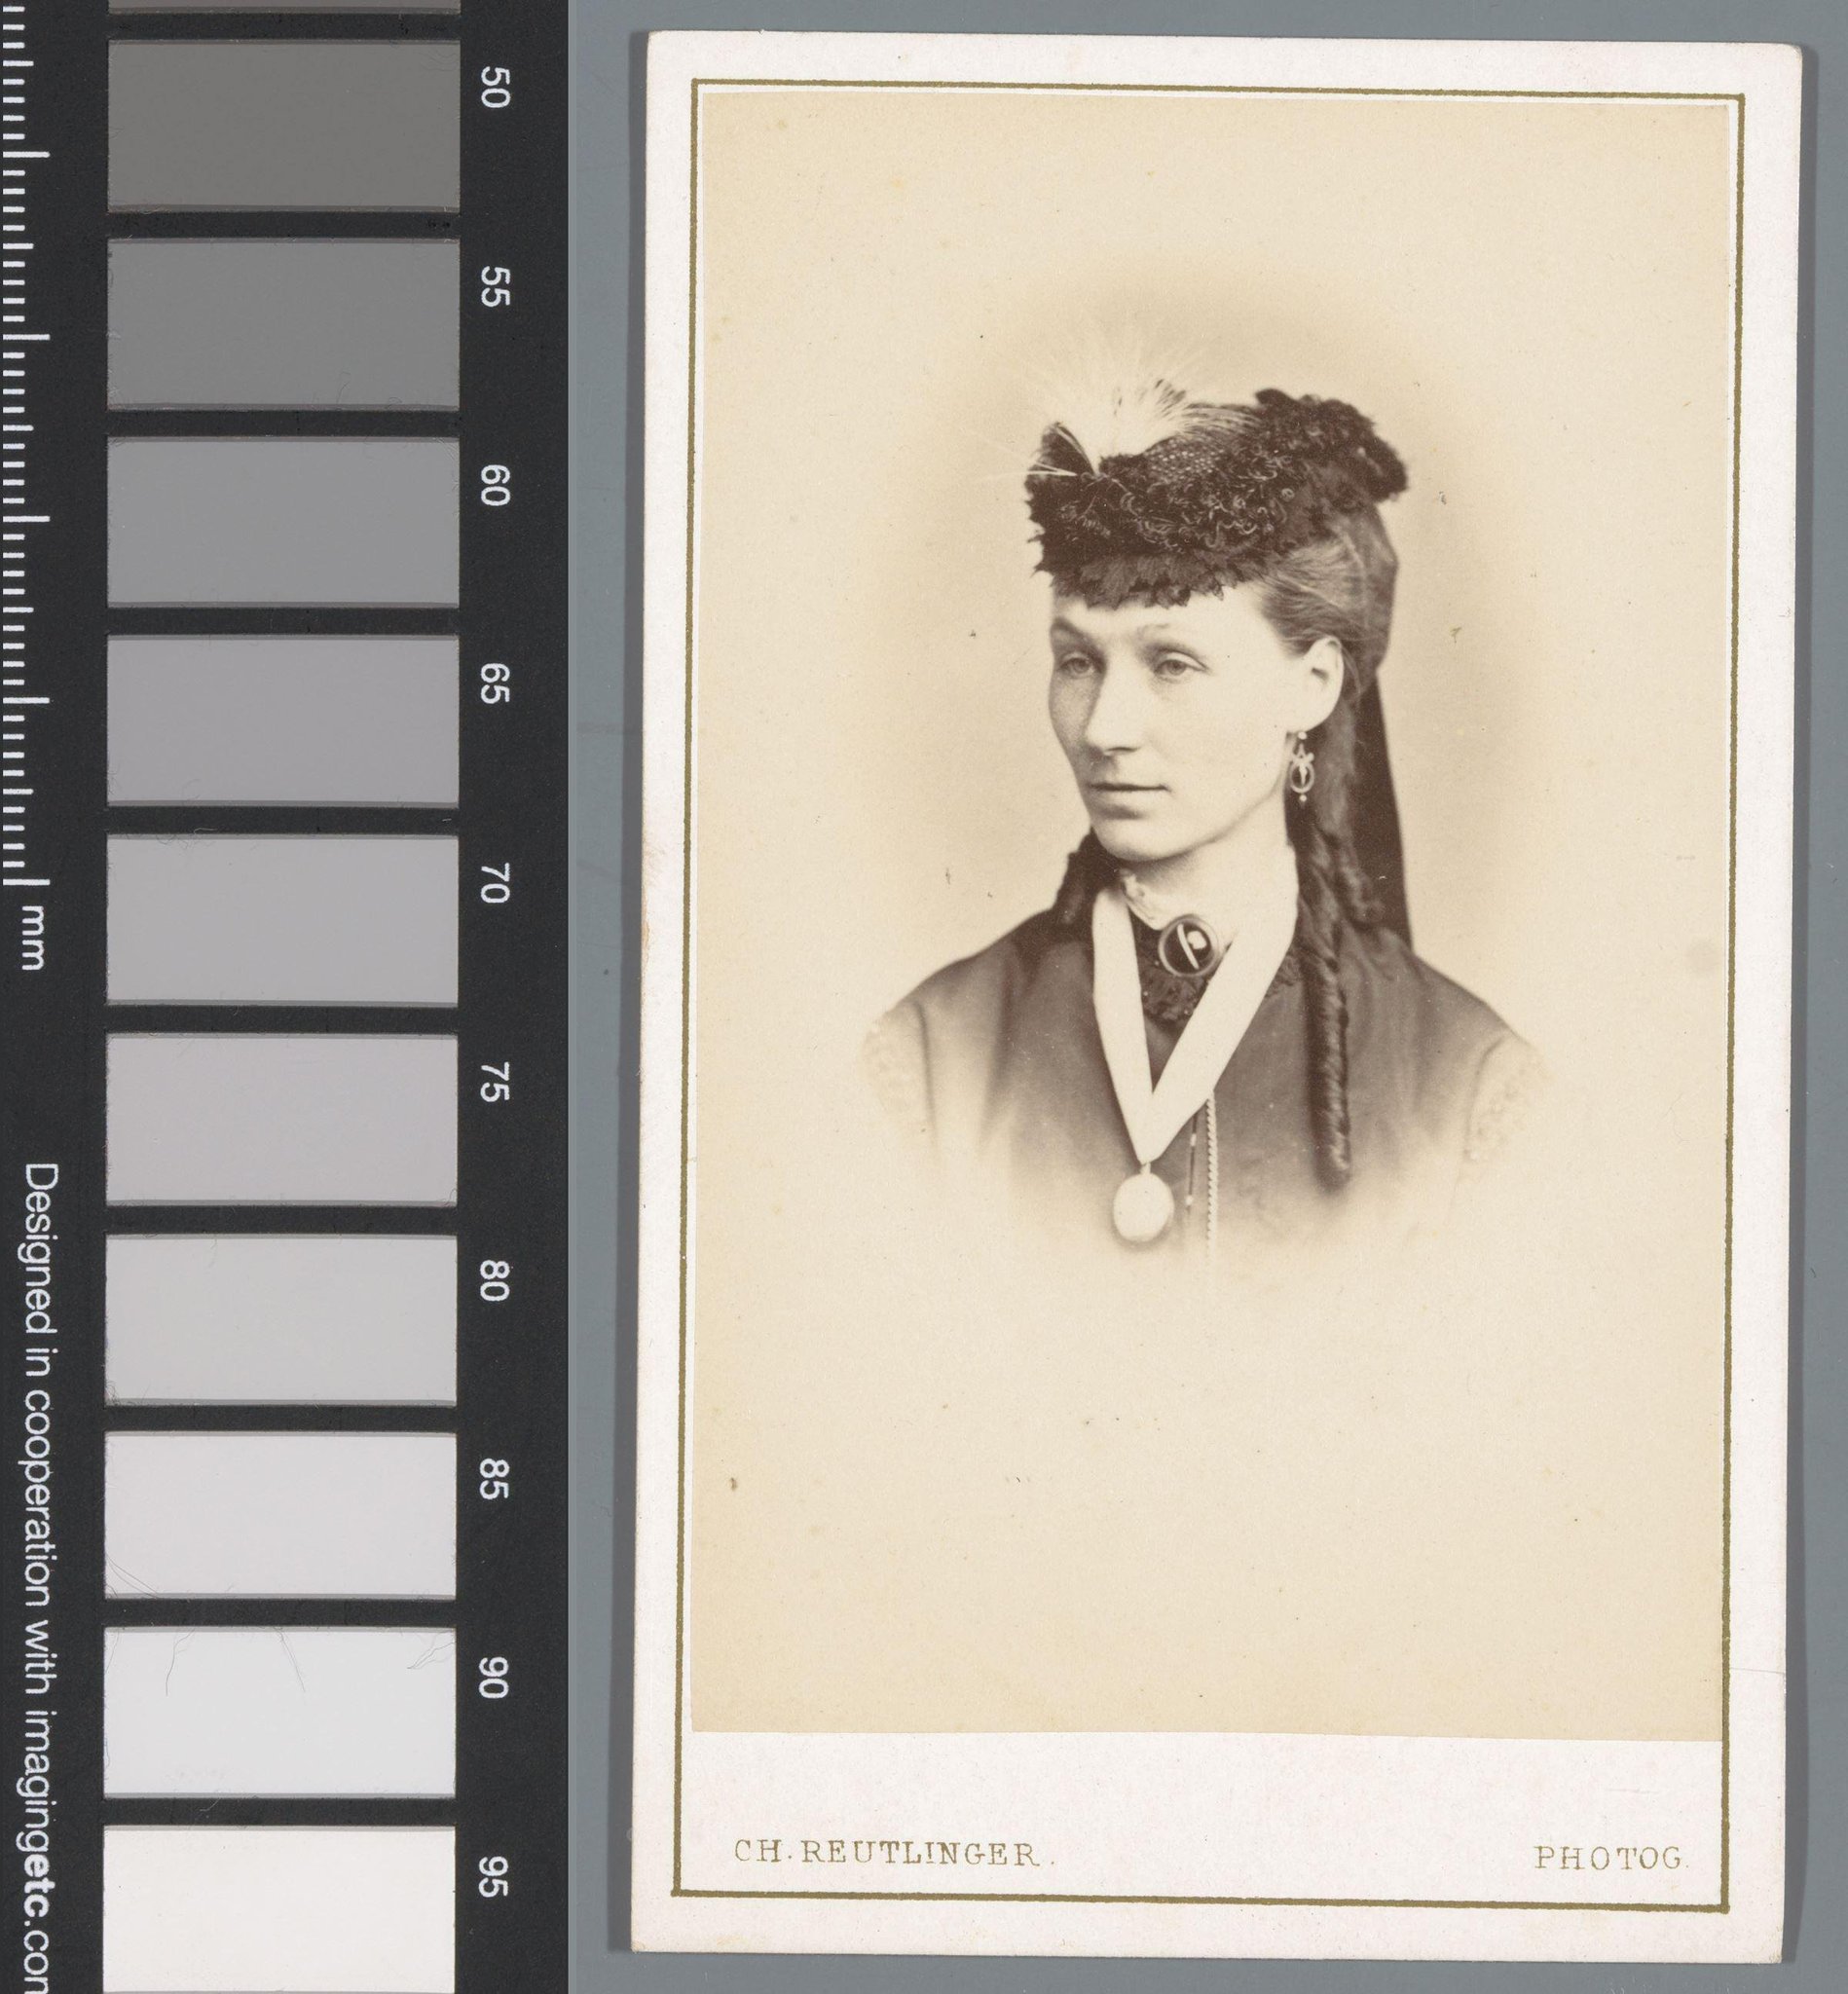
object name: photograph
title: Portret van een onbekende vrouw met een hoofddeksel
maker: charles reutlinger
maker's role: publisher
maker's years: 1816-1880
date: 1867-1880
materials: cardboard, paper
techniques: albumen print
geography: paris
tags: historical persons - bb - woman, pendant, trinket, 'breloque', head-gear: hat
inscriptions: inscription: ‘PREMIER PRIX/ Exposition Universelle 1867/ CH. REUTLINGER/ PHOTOGRAPHE/ 21, Boulevard Montmartre, 21,/ PARIS/ Les Clichés étant conservés indéfiniment,/ on peut toujours se procurer de nouvelles/ épreuves de Cartes & Portraits sans reposer.’